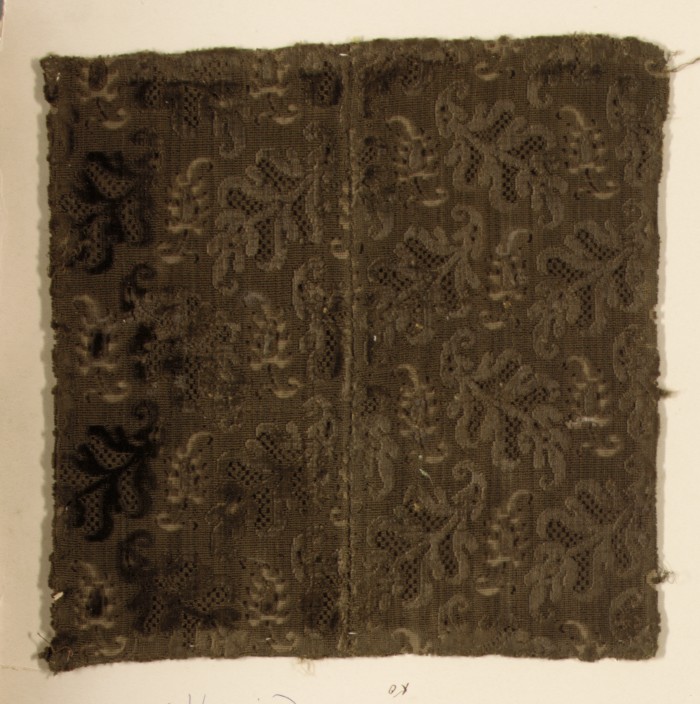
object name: fragment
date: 1534-1566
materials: silk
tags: flowers